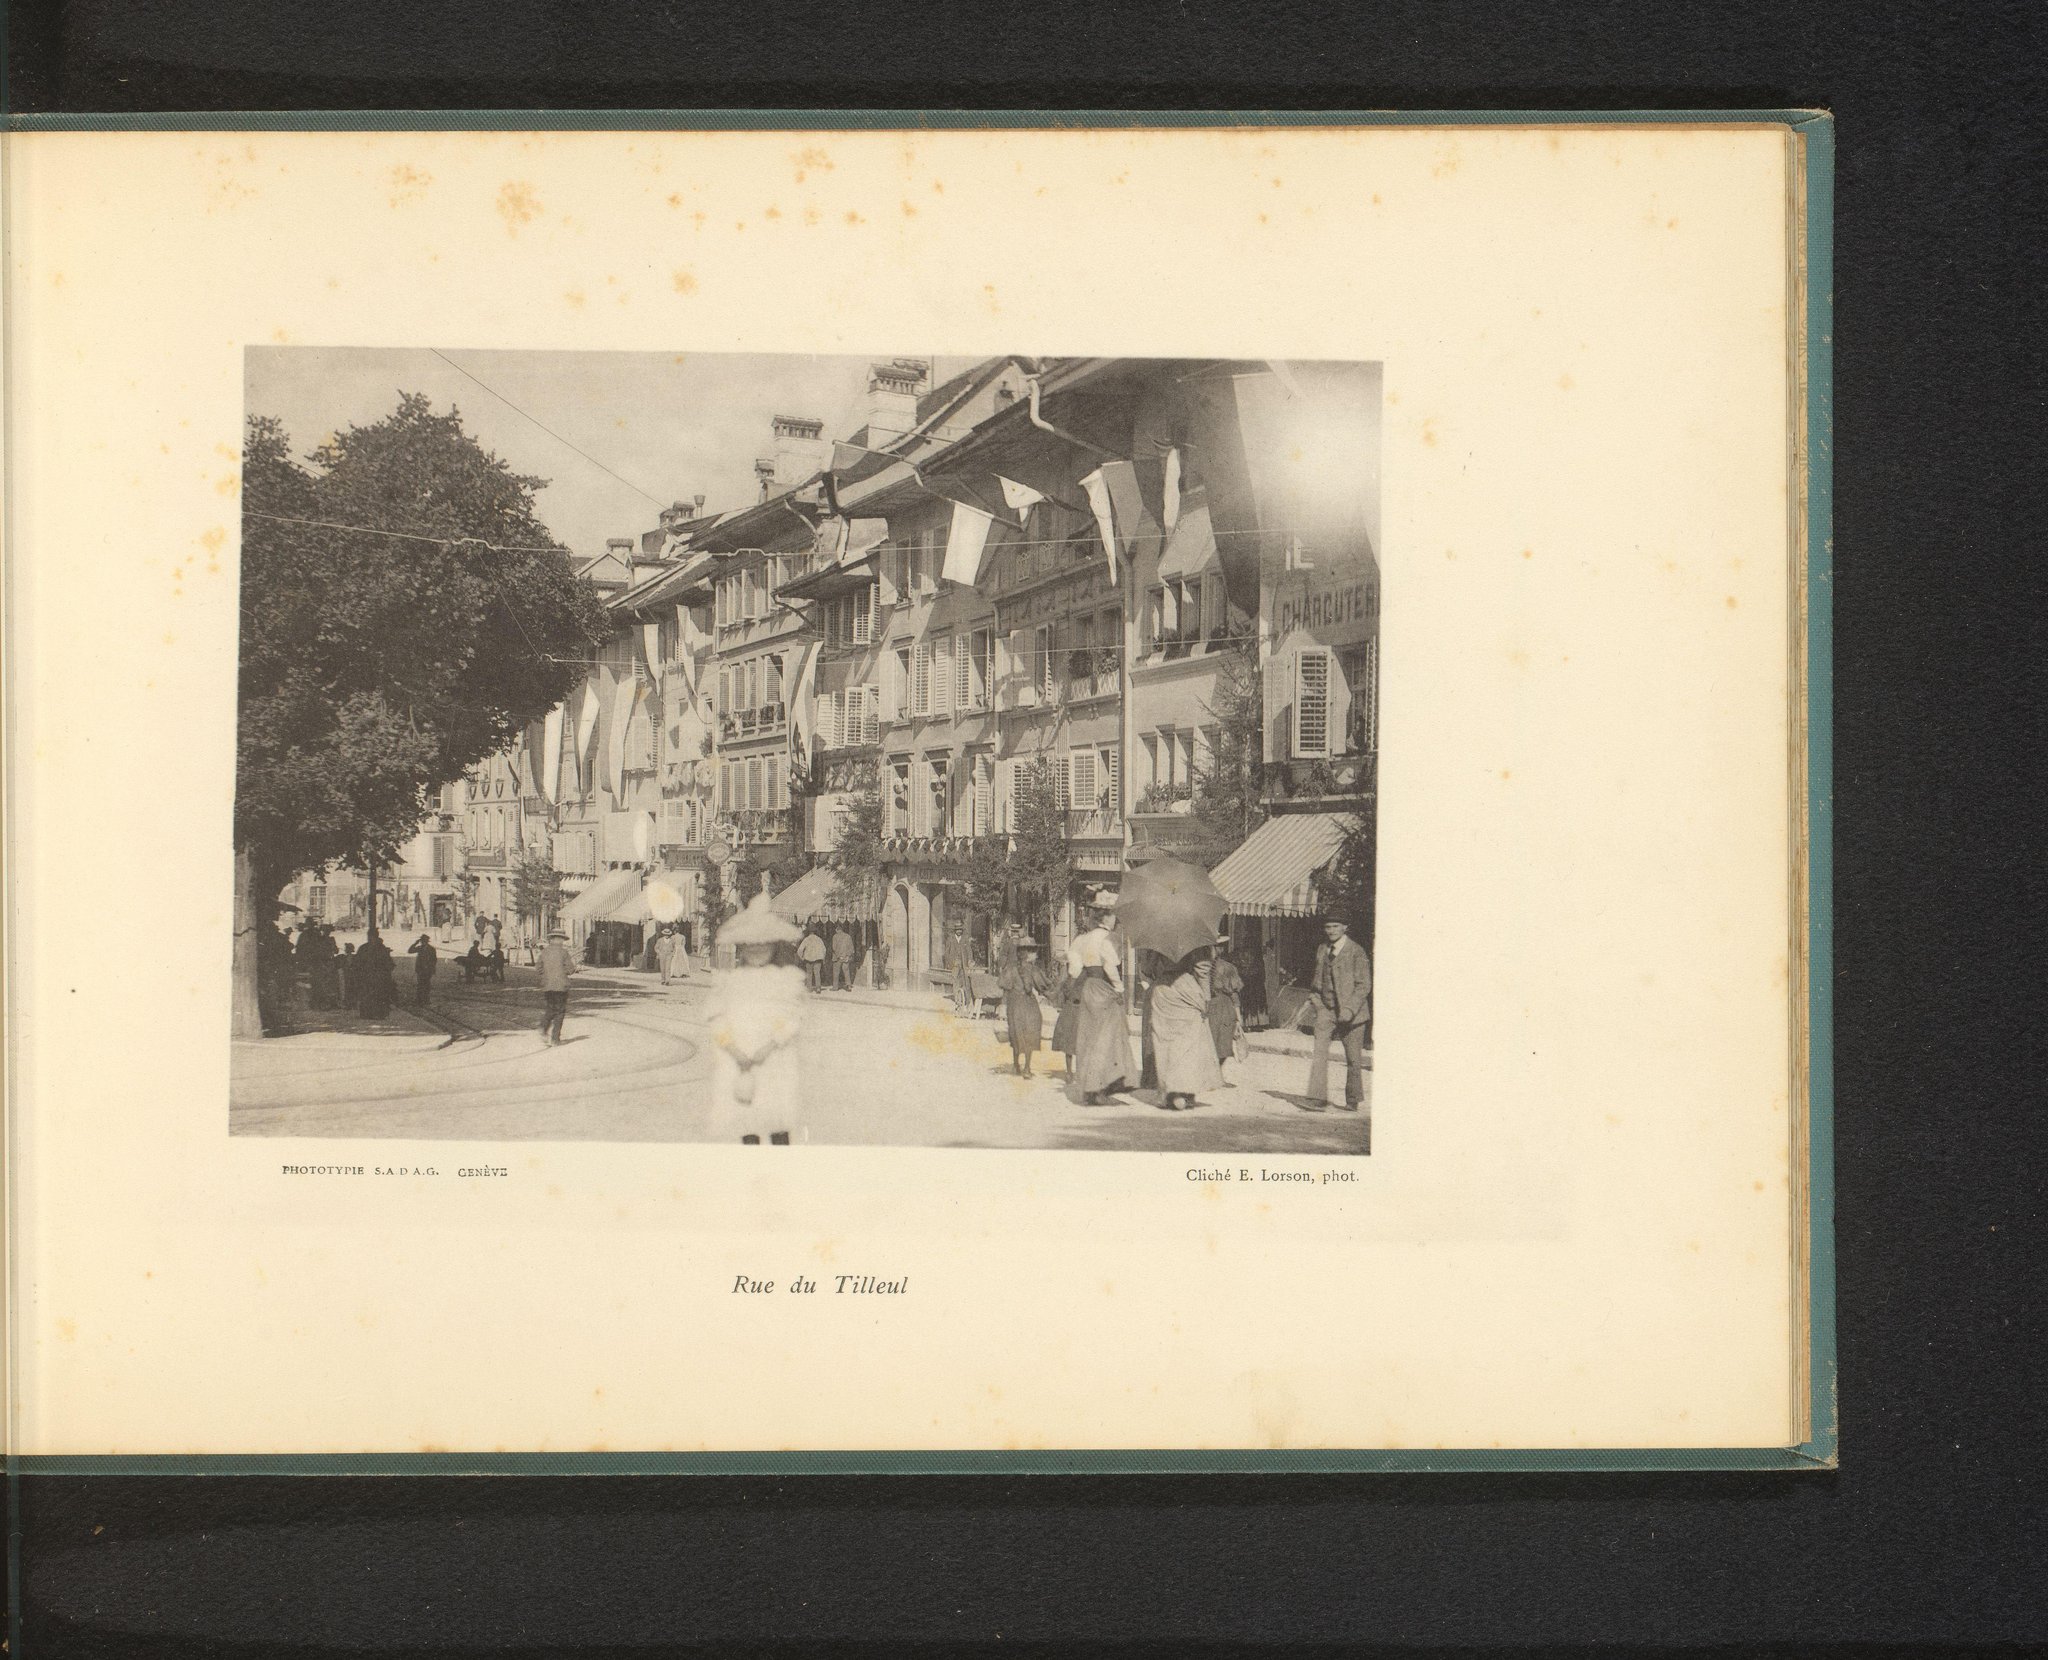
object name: page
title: Rue du Tilleul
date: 1897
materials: paper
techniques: photograph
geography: geneva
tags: tram, street, flag, colours (as symbol of the state, etc.)